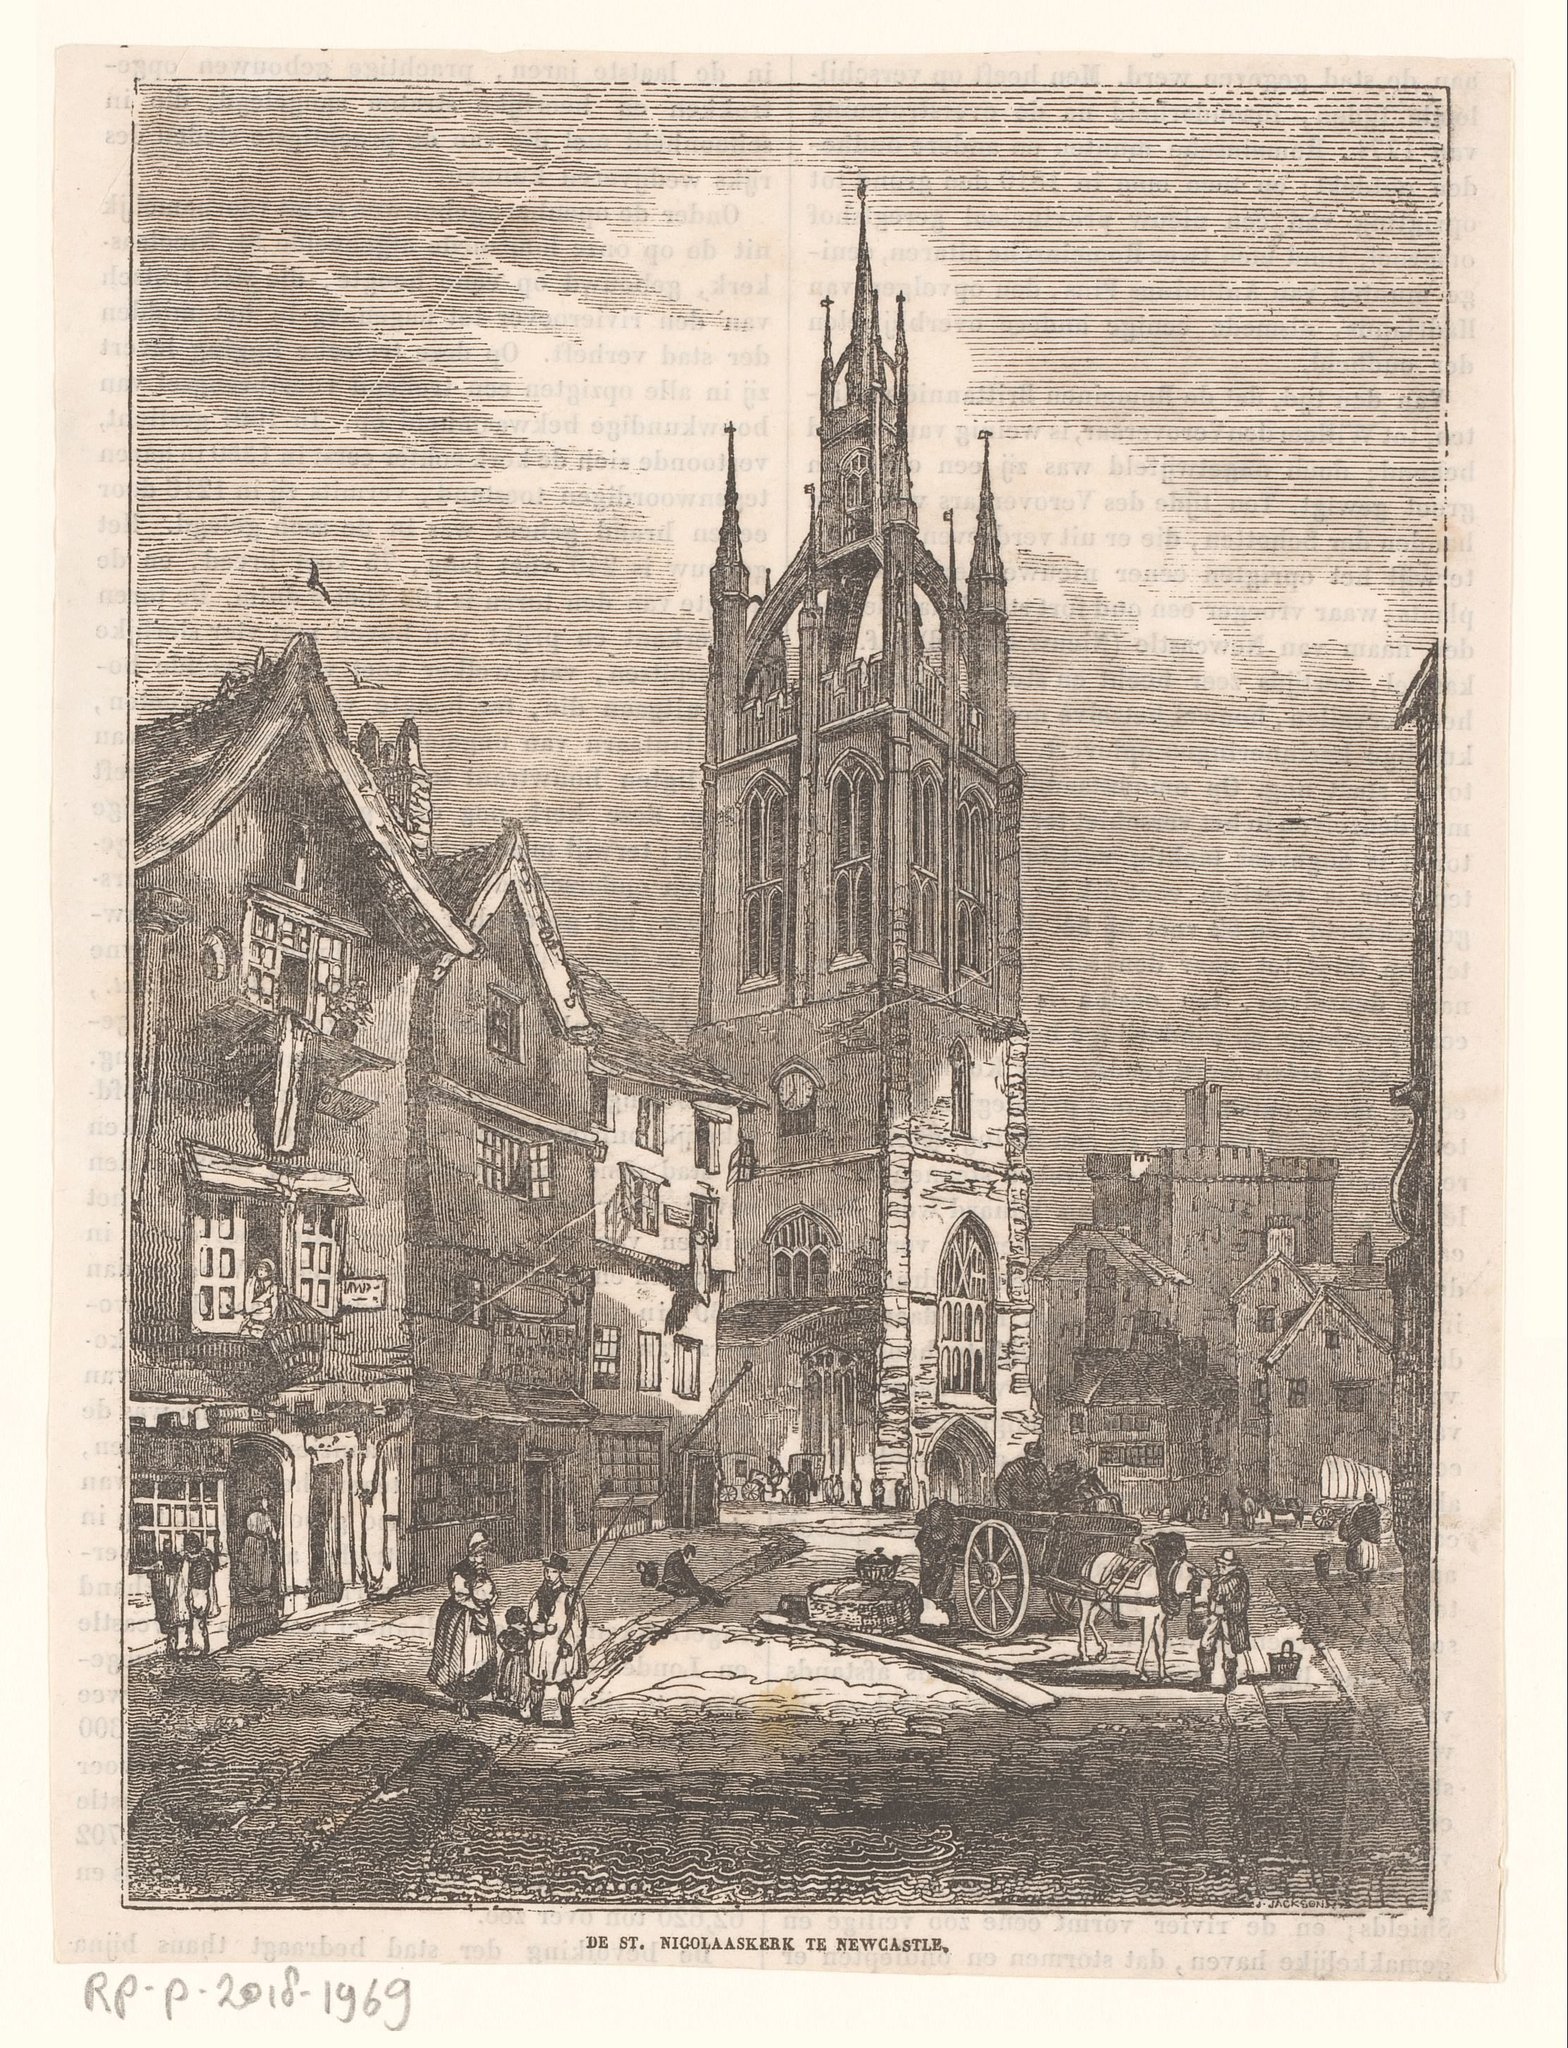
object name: print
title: De St. Nicolaaskerk te Newcastle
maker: john jackson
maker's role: print maker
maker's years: 1801-1848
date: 1837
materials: paper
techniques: letterpress printing, engraving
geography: amsterdam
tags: church (exterior)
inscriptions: collector's mark: Lugt 2228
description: Prent gebruikt in: Nederlandsch Magazijn ter verspreiding van algemeene en nuttige kundigheden. Amsterdam: Gebroeders Diederichs, 1837.